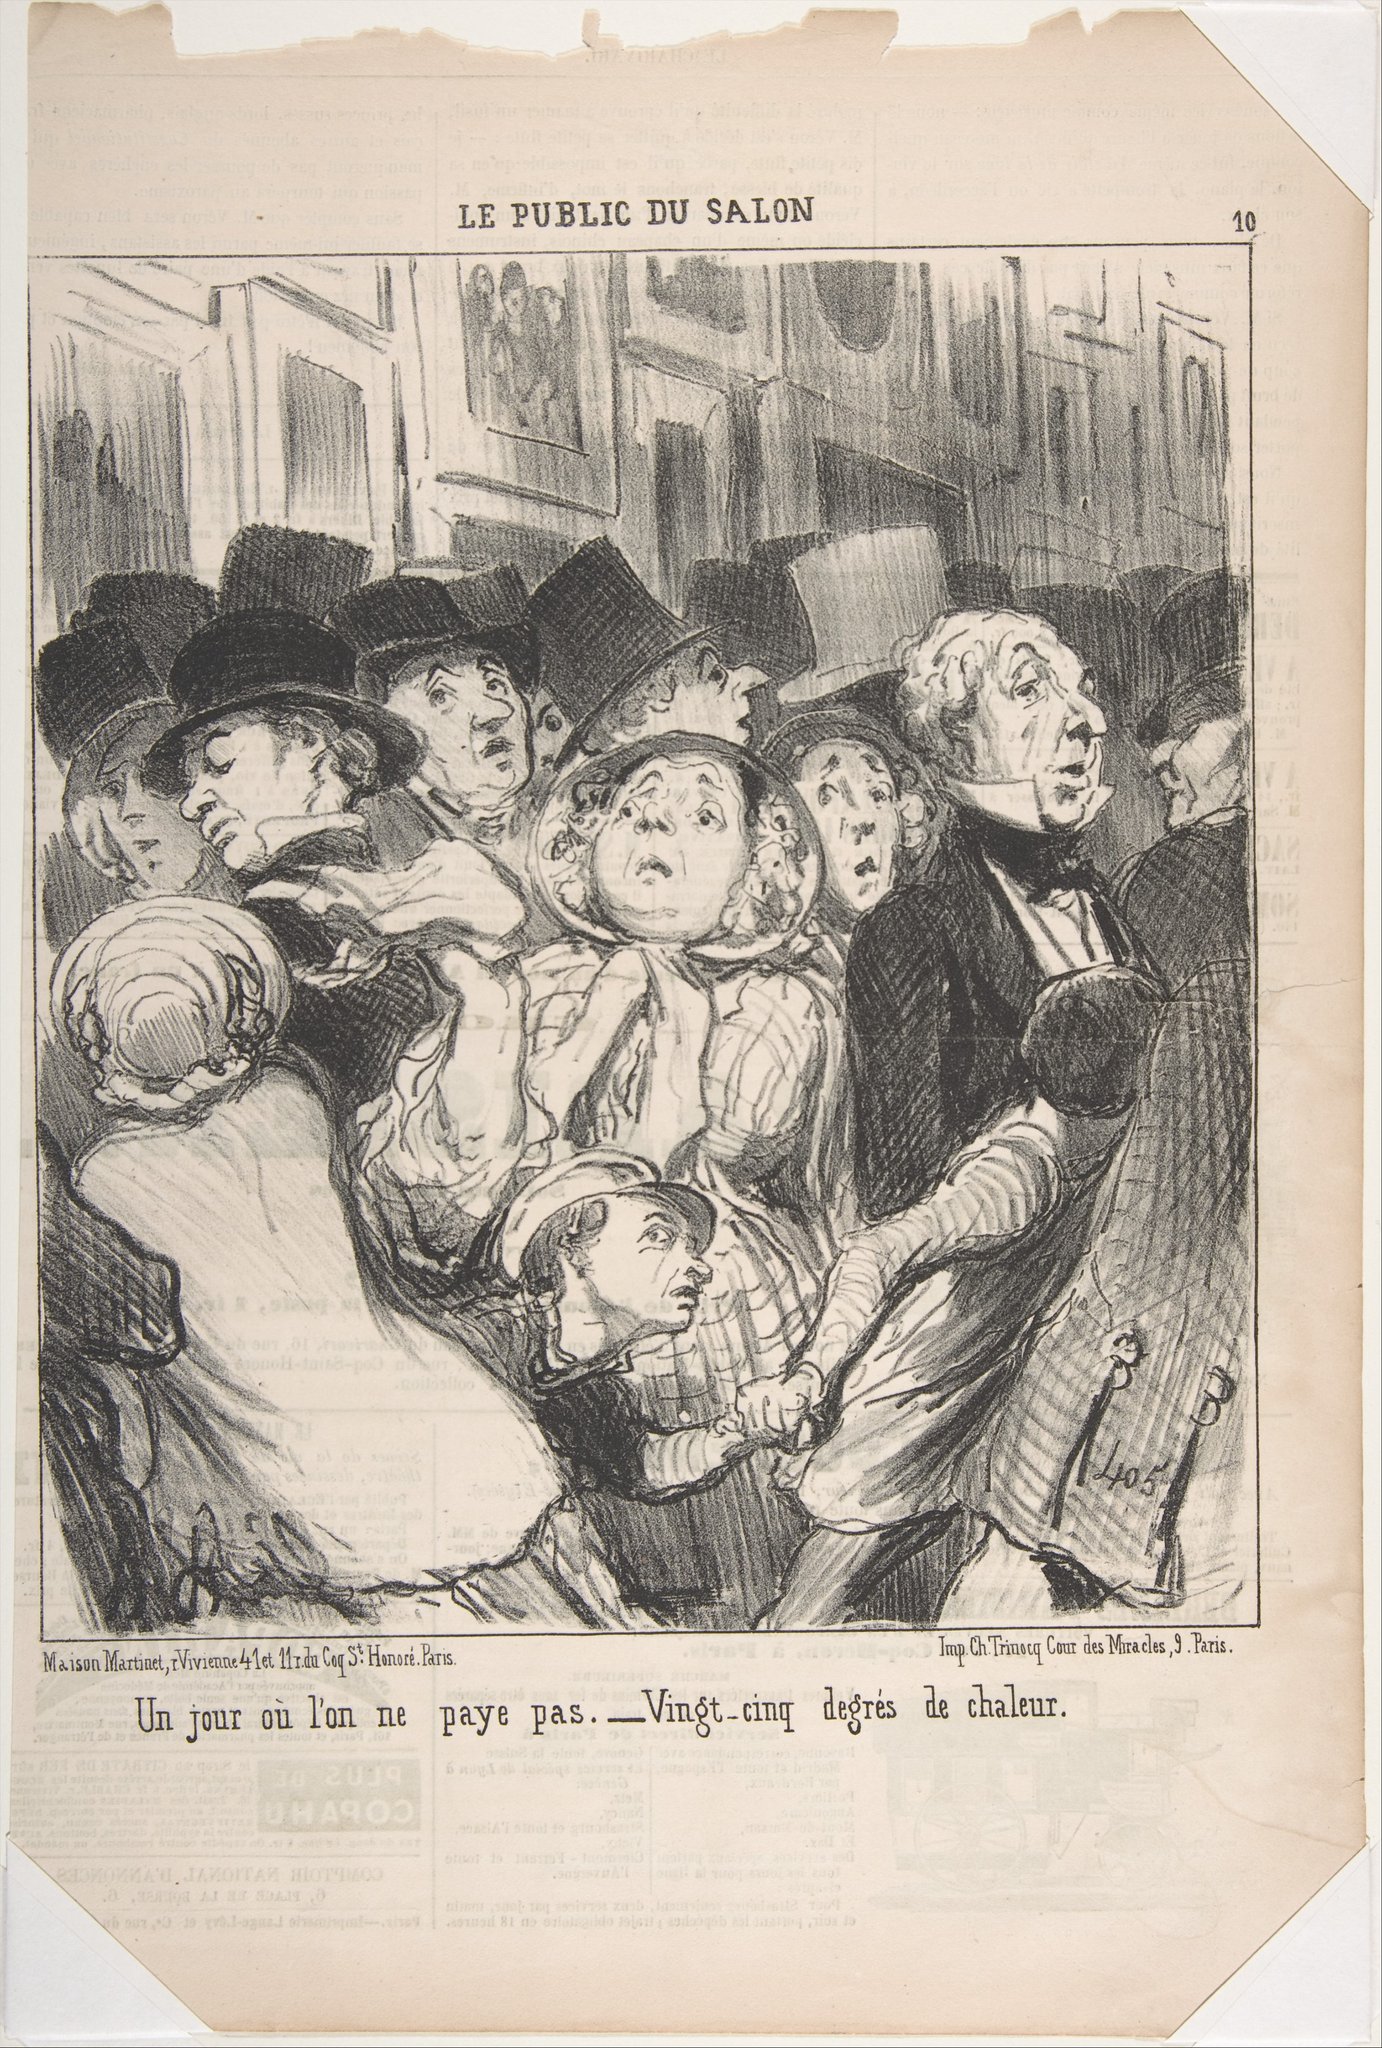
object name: print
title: A Day When You Do Not Pay–Twenty-Five-Degree Heat (Un jour ou l'on ne paye pas. Vingt-cinq degres de chaleur ), from Le Public du Salon, published in Le Charivari, May 17, 1852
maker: honoré daumier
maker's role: artist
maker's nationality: french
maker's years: 1808-1879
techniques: lithograph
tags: men,women,crowd